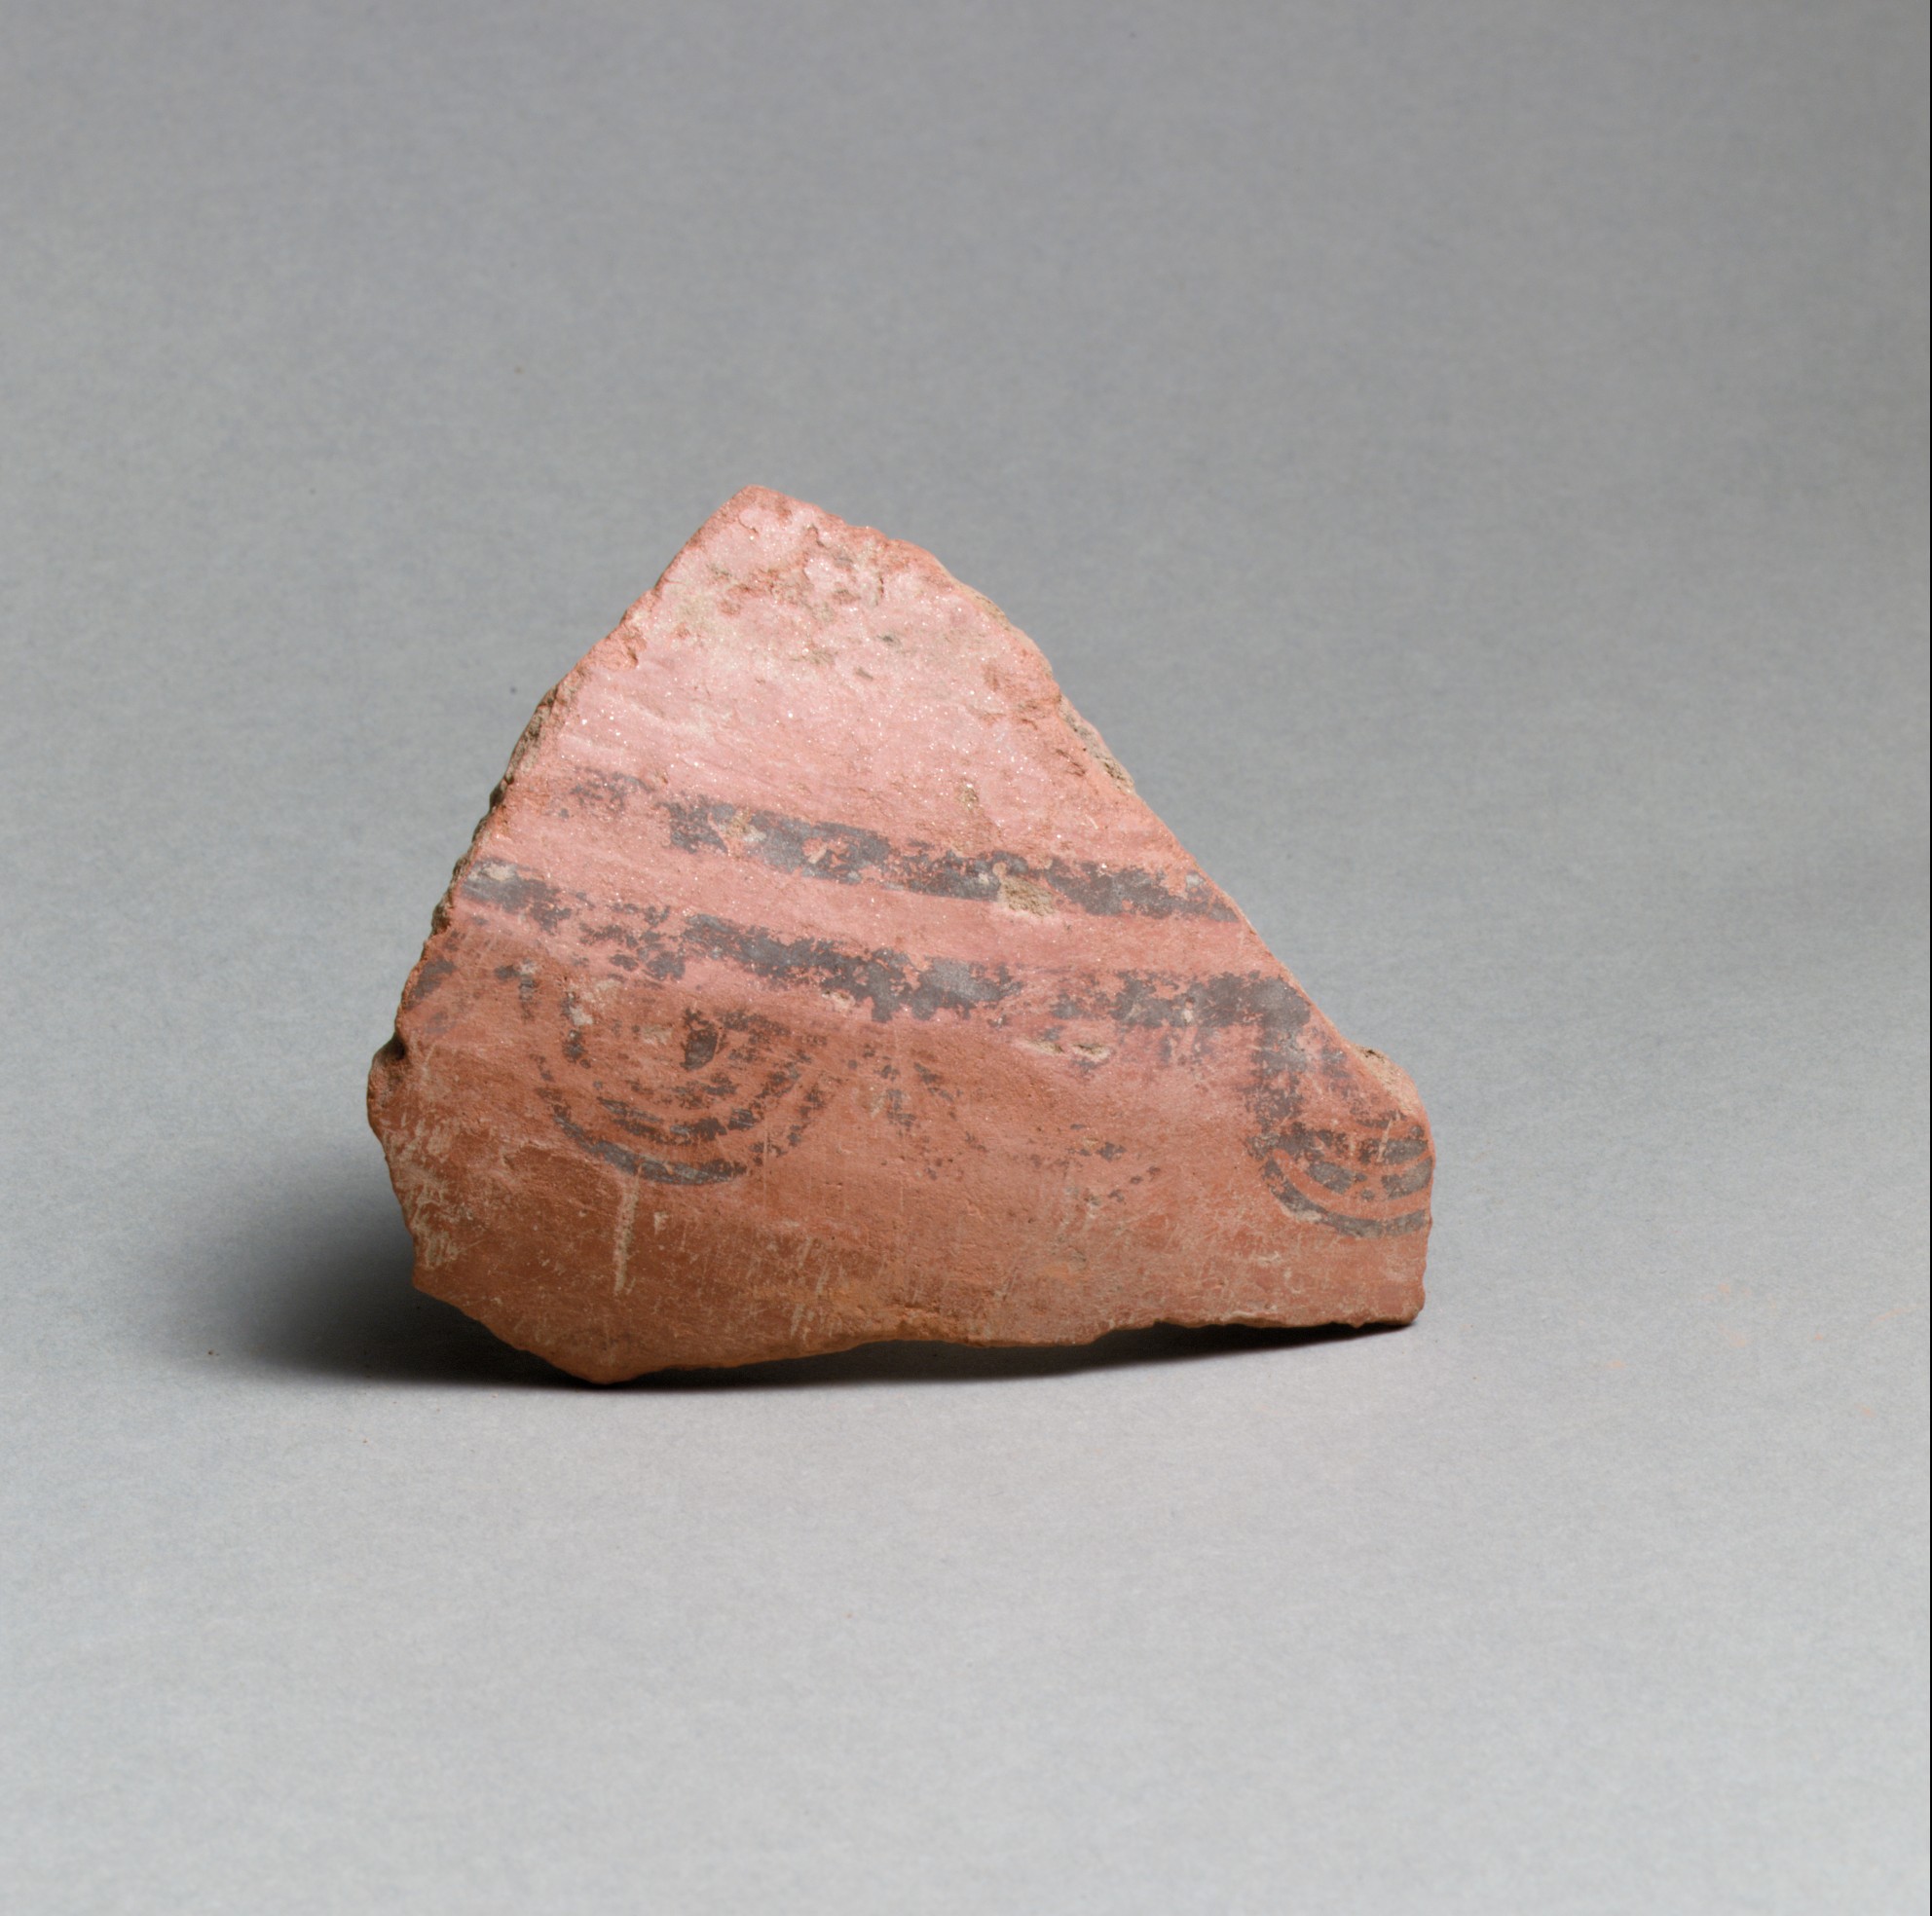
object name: vase fragment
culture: greek or lydian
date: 1050-700 BCE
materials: terracotta